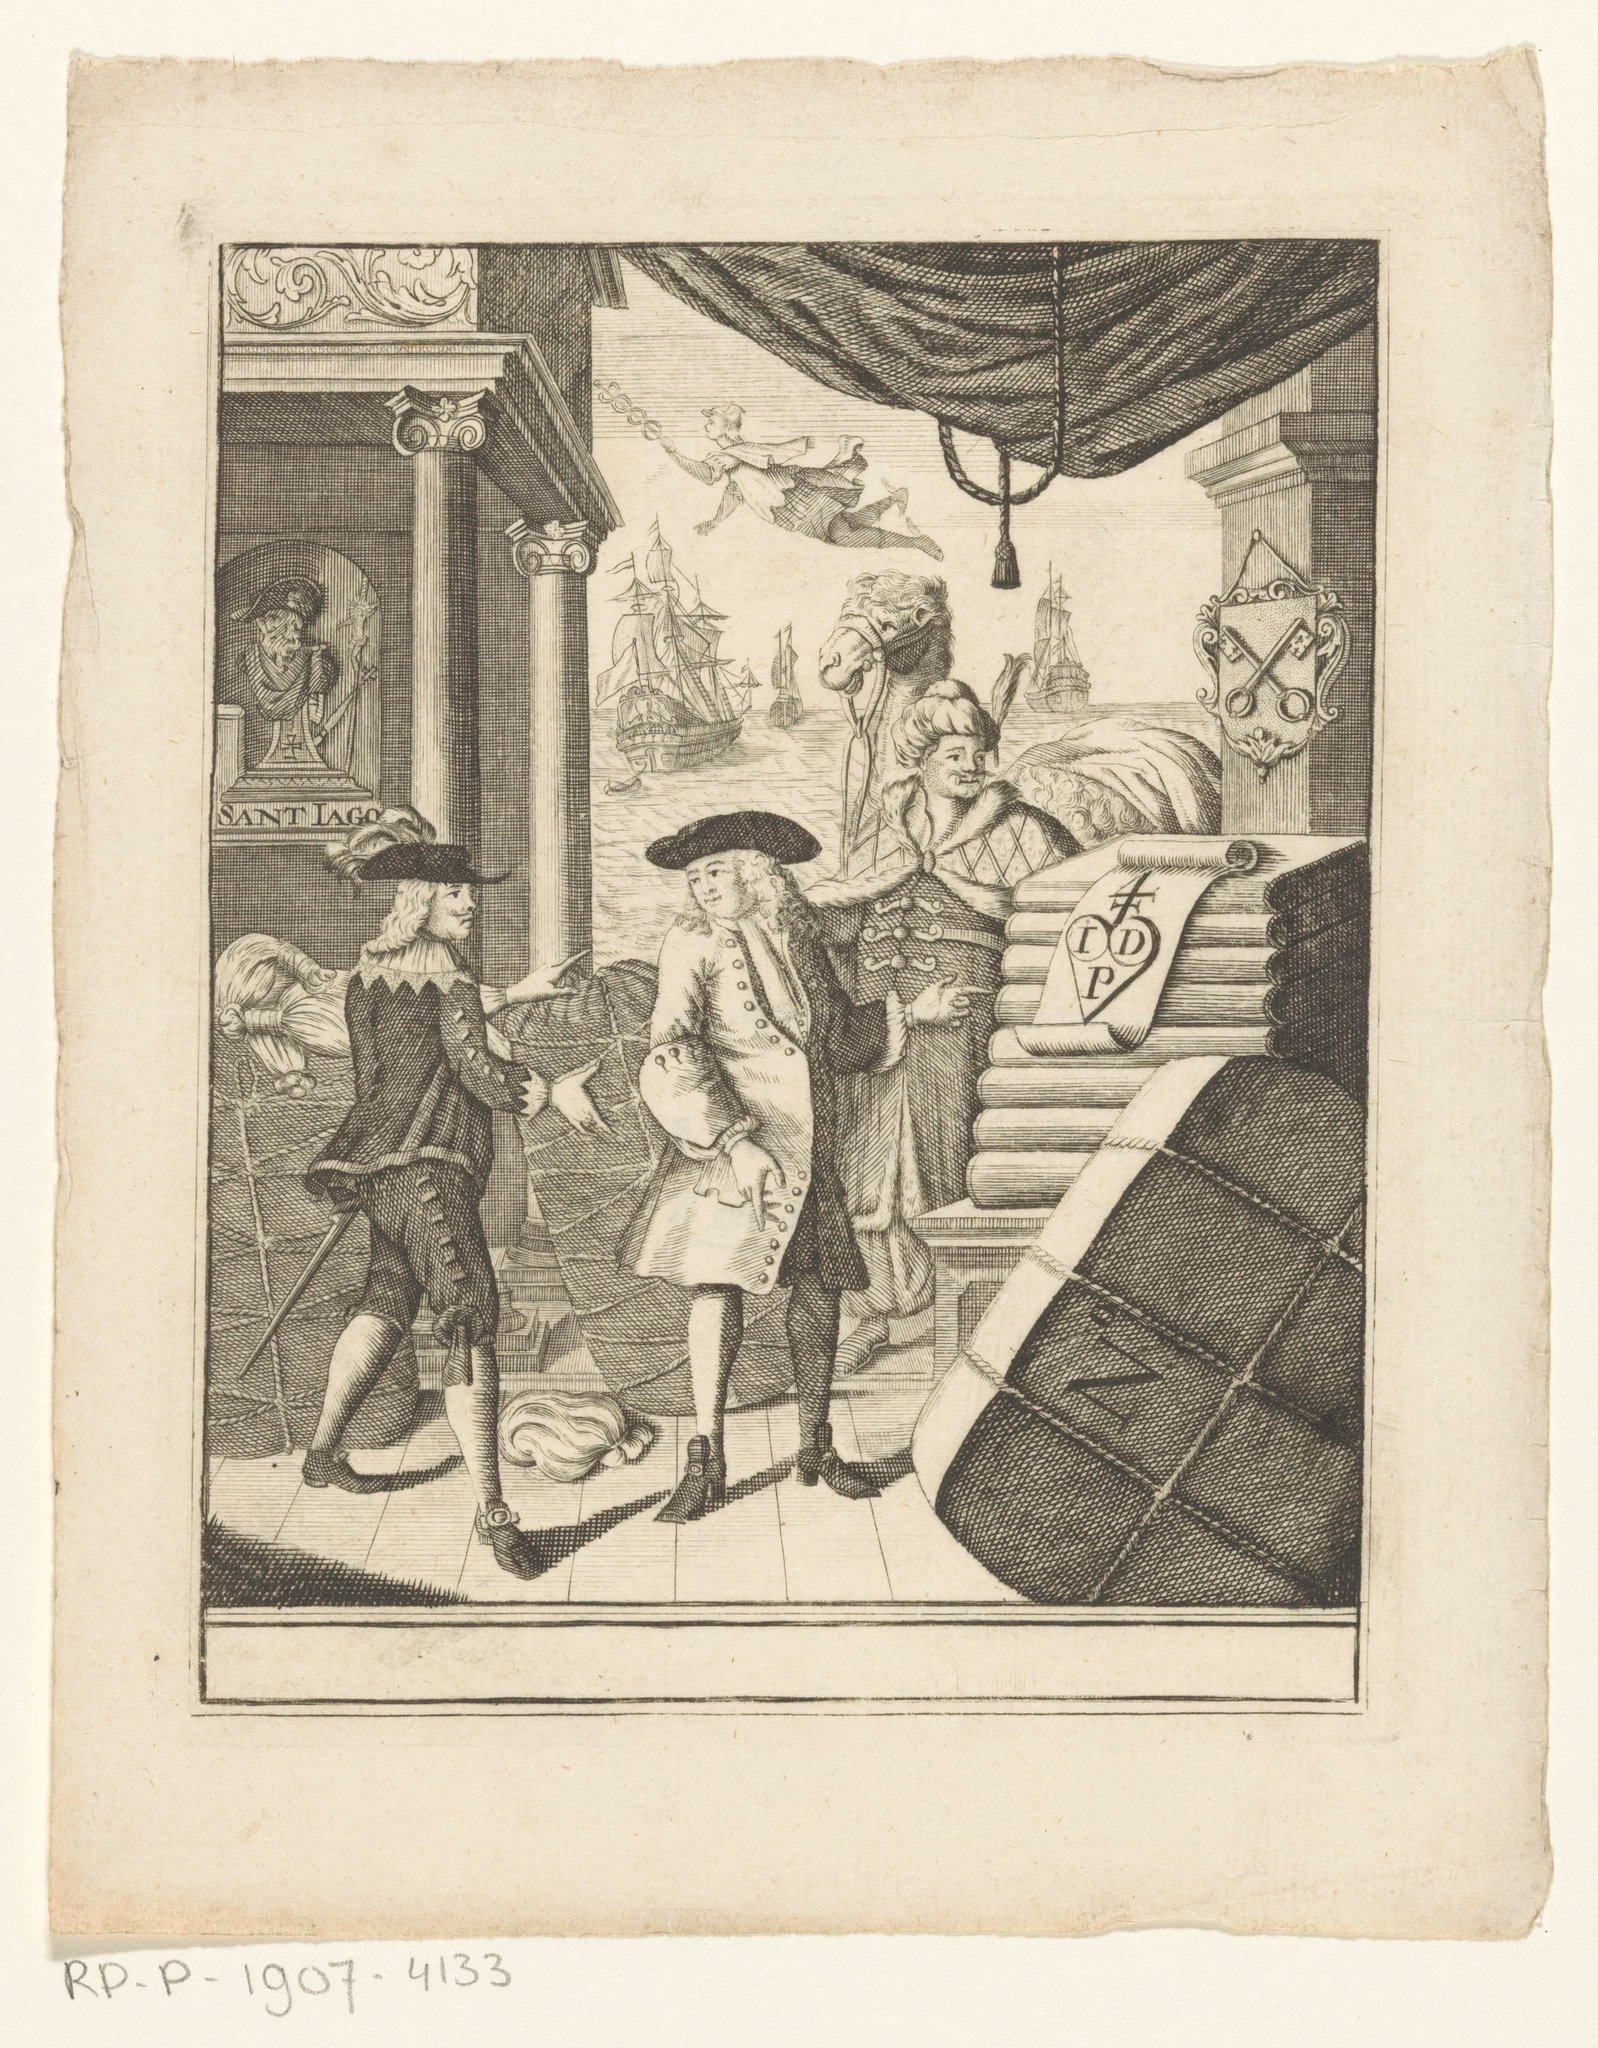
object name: print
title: Handelsetiket van Leidse lakenkoopmannen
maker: Anonymous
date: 1700-1799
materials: paper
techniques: engraving, etching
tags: trade-company, (story of) mercury (hermes), textile industry and clothing industry, leiden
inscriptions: collector's mark: Lugt 2228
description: Twee lakenkoopmannen staan naast balen textiel. Achter hen staat een buitenlandse handelaar met tulband en kameel. Rechts hangt het wapen van Leiden. Links een buste van Jakobus de Meerdere in een nis. In de achtergrond schepen op zee en Mercurius met caduceus.